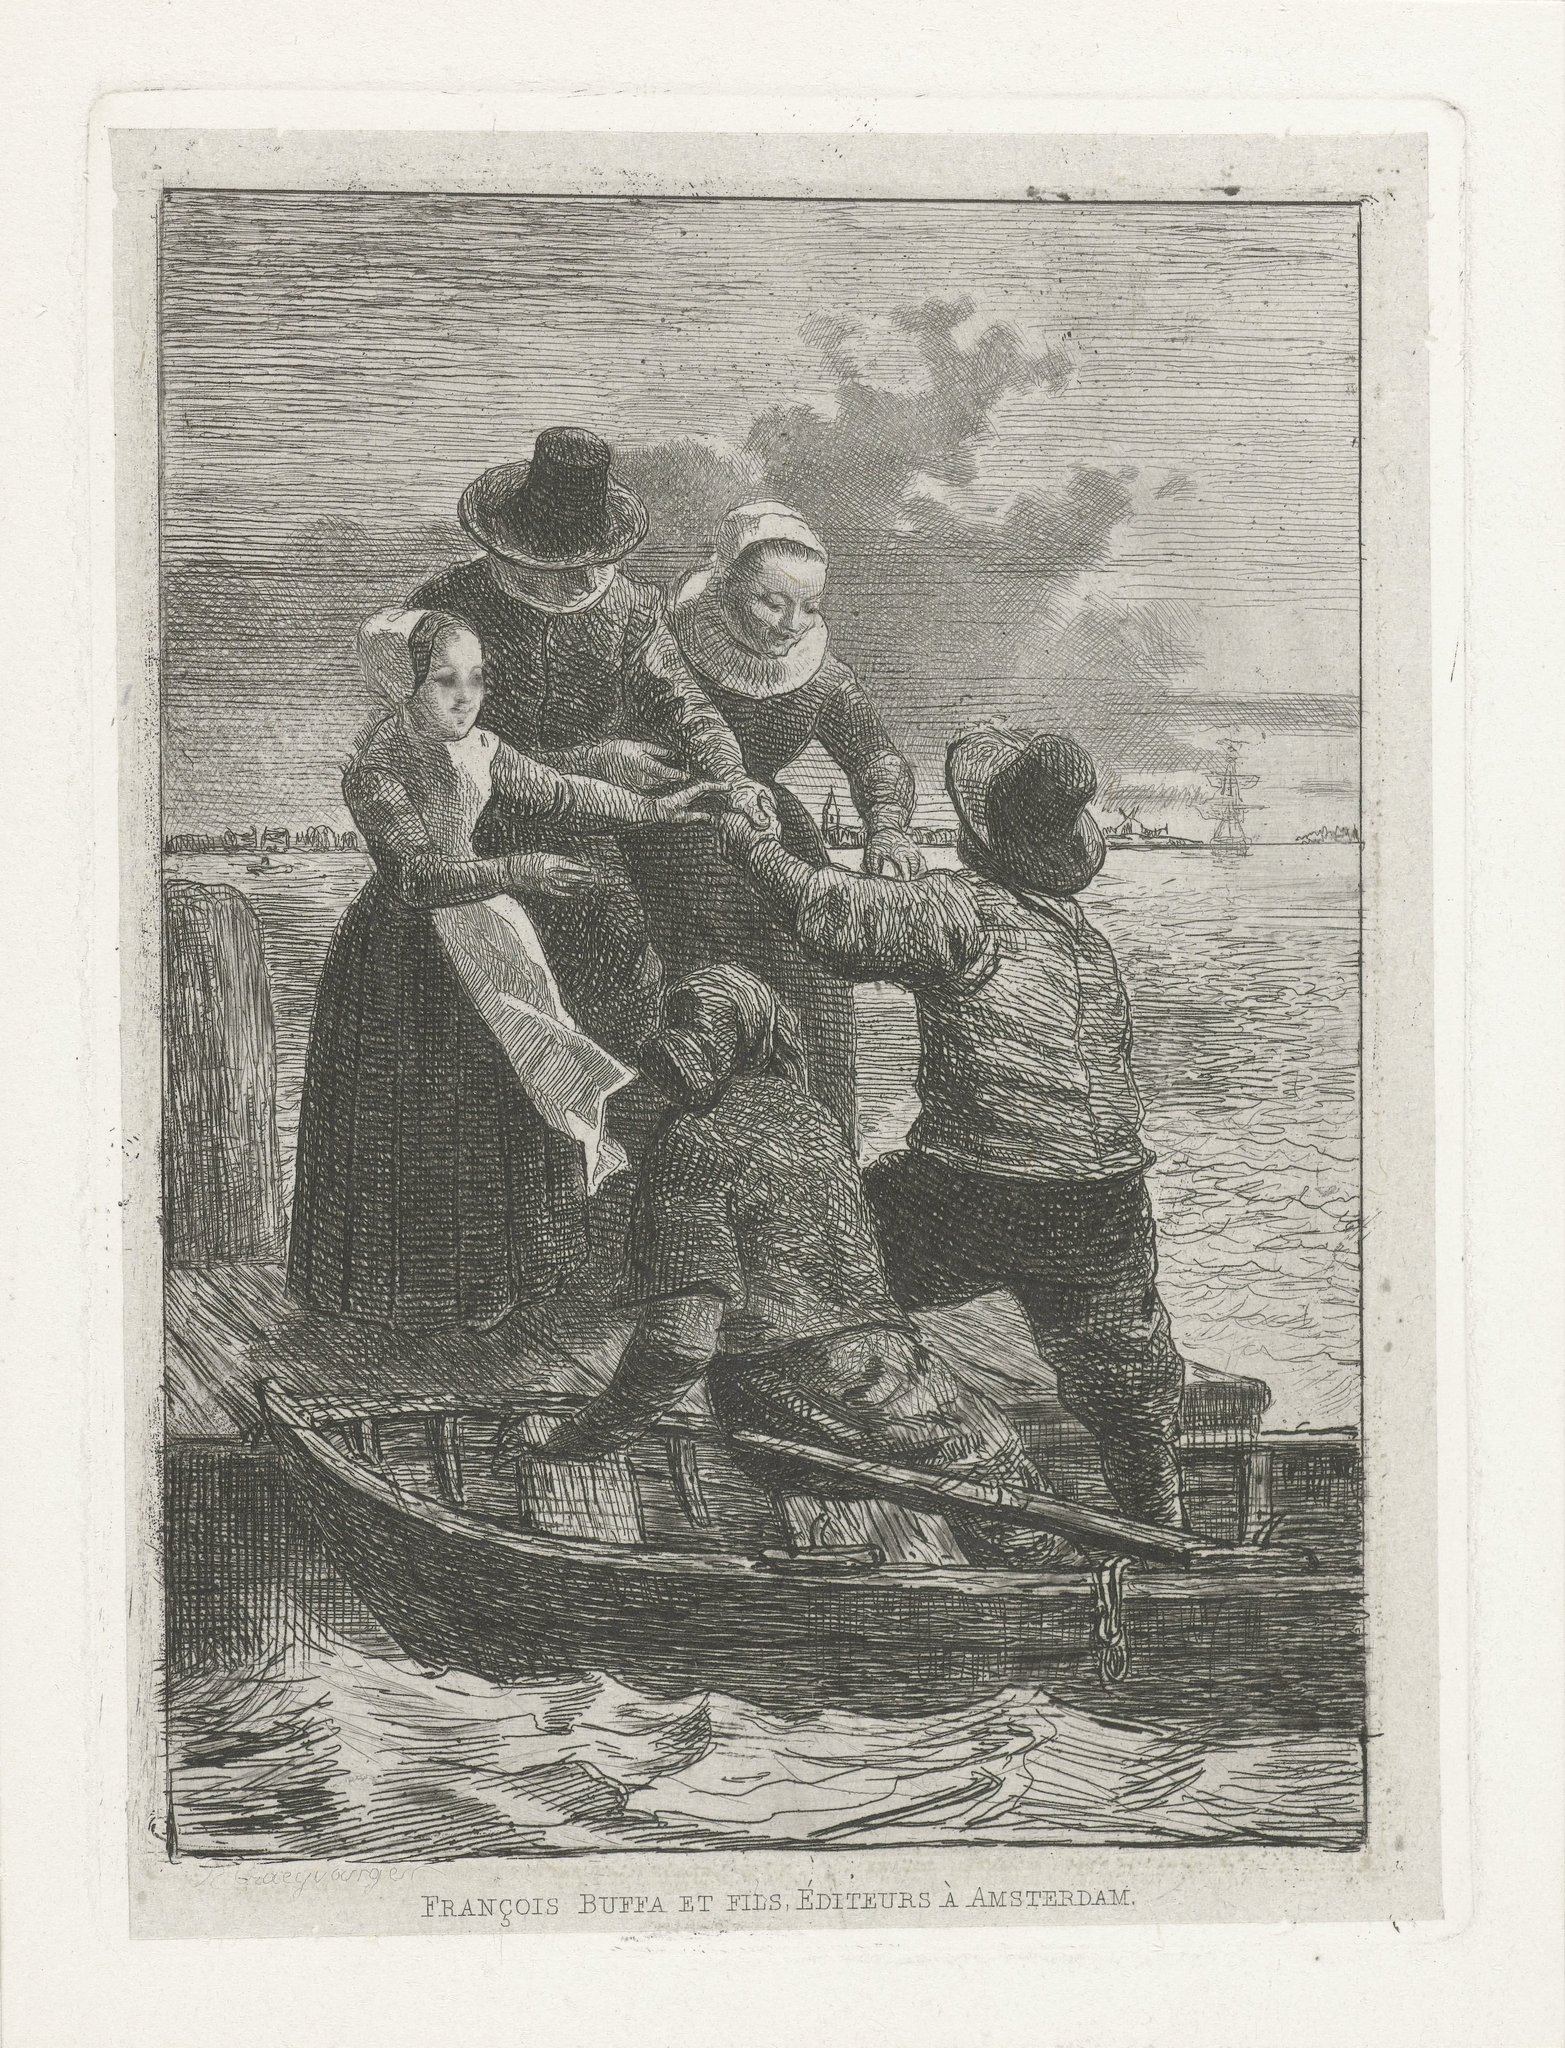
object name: print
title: Inscheping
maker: reinier craeyvanger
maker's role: draughtsman, print maker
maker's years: 1812-1880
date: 1822-1880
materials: paper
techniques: etching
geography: amsterdam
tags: family group, especially parents with their child(ren), rowing-boat, canoe, etc., seaman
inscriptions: collector's mark: Lugt 2228, caption: ‘Francois Buffa et Fils, Éditeurs à Amsterdam’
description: Een schipper helpt een gezin van een vader, een moeder en een dochter met inschepen op de roeiboot.